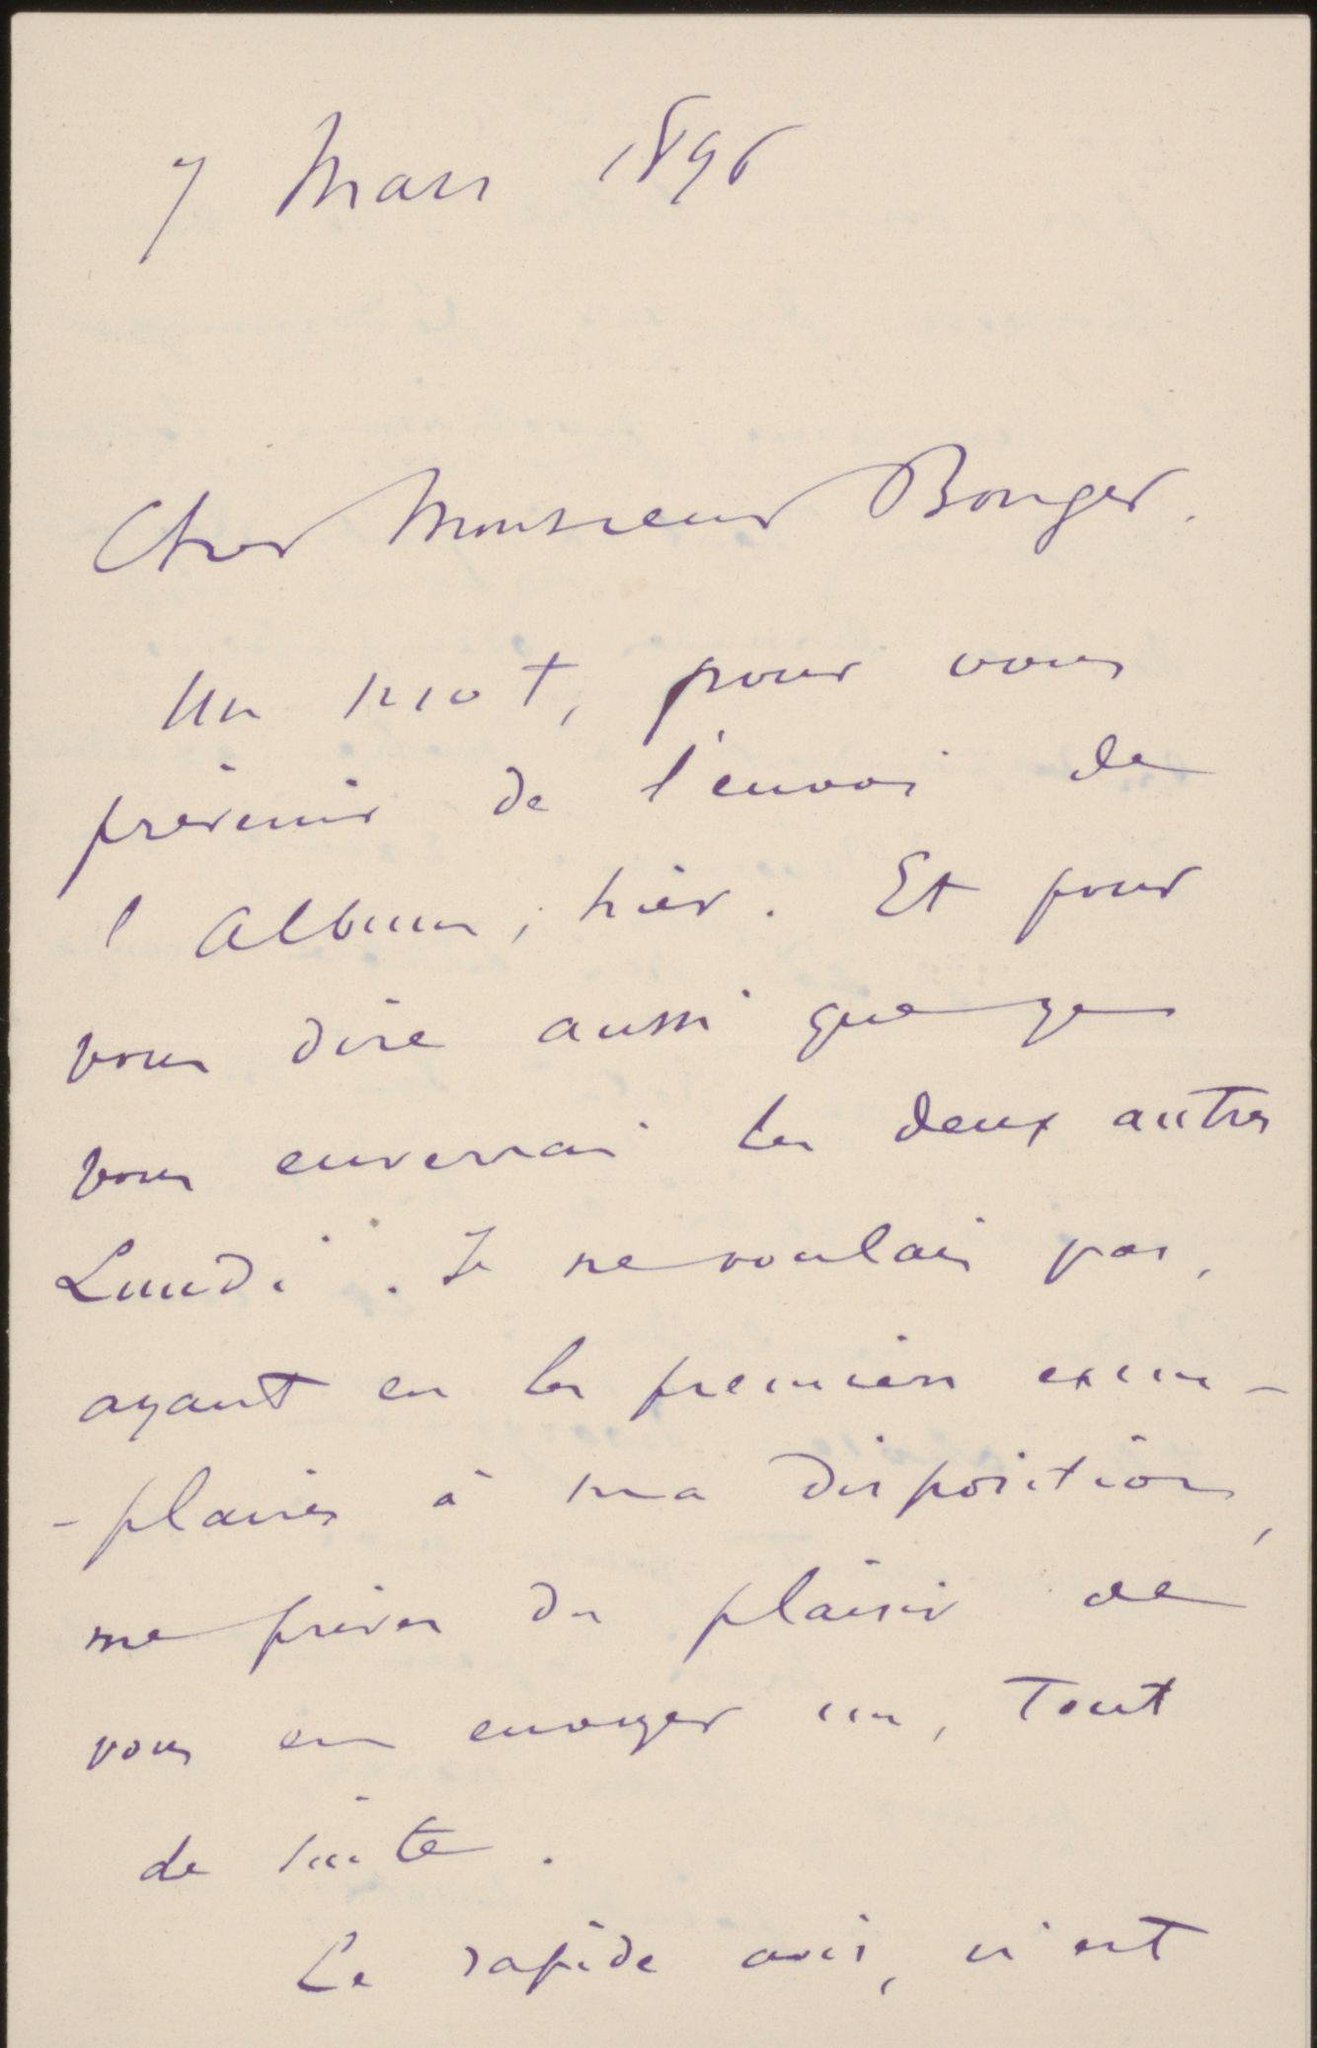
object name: letter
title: Brief aan Andries Bonger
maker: odilon redon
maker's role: draughtsman, painter, print maker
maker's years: 1840-1916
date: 1896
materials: ink, paper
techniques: pen, writing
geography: paris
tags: andries bonger, diseases, printed matter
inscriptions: watermark